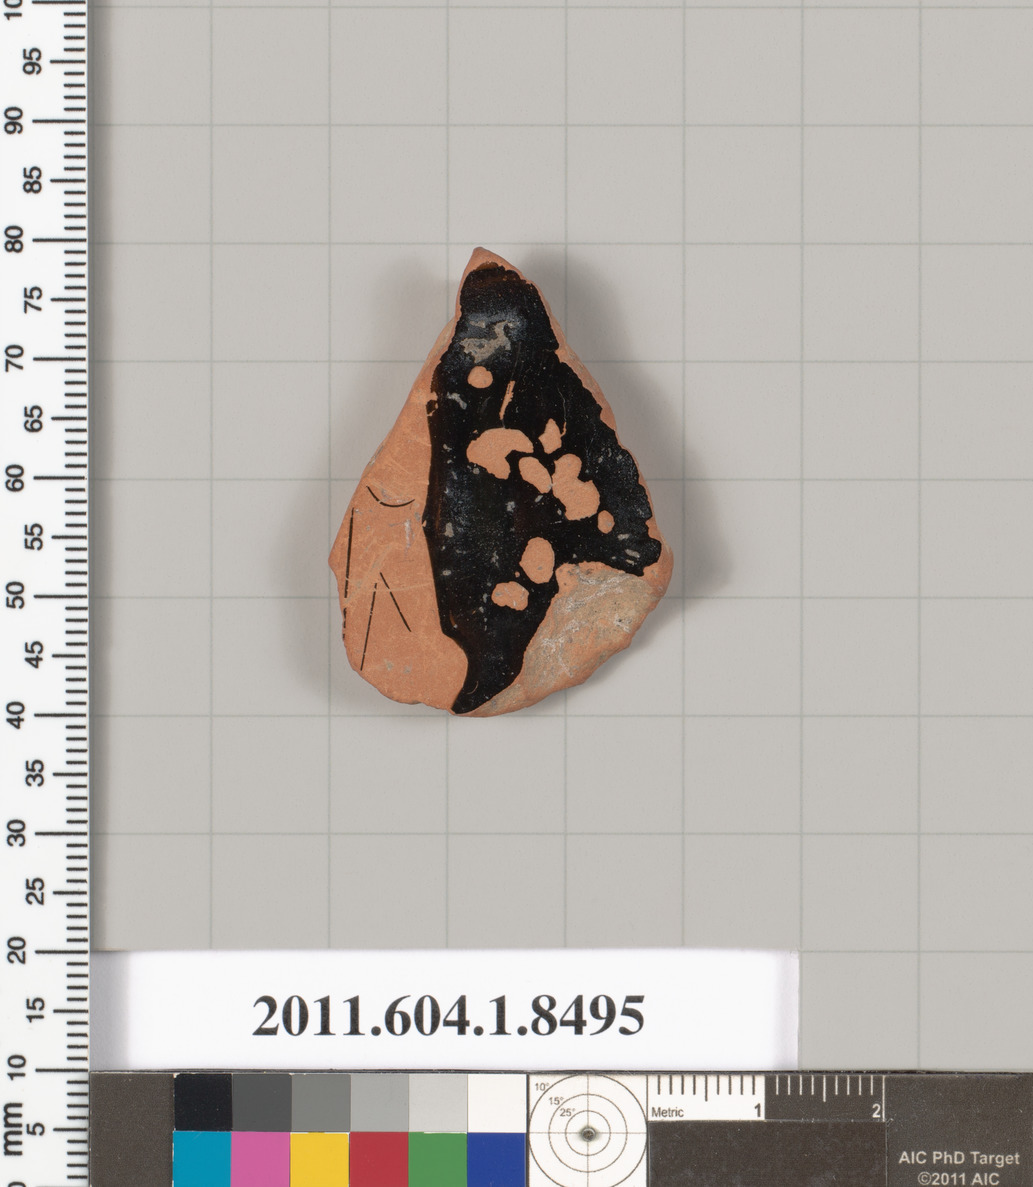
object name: kylix fragment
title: Terracotta fragment of a stemless kylix (drinking cup)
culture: greek, attic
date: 460-450 BCE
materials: terracotta